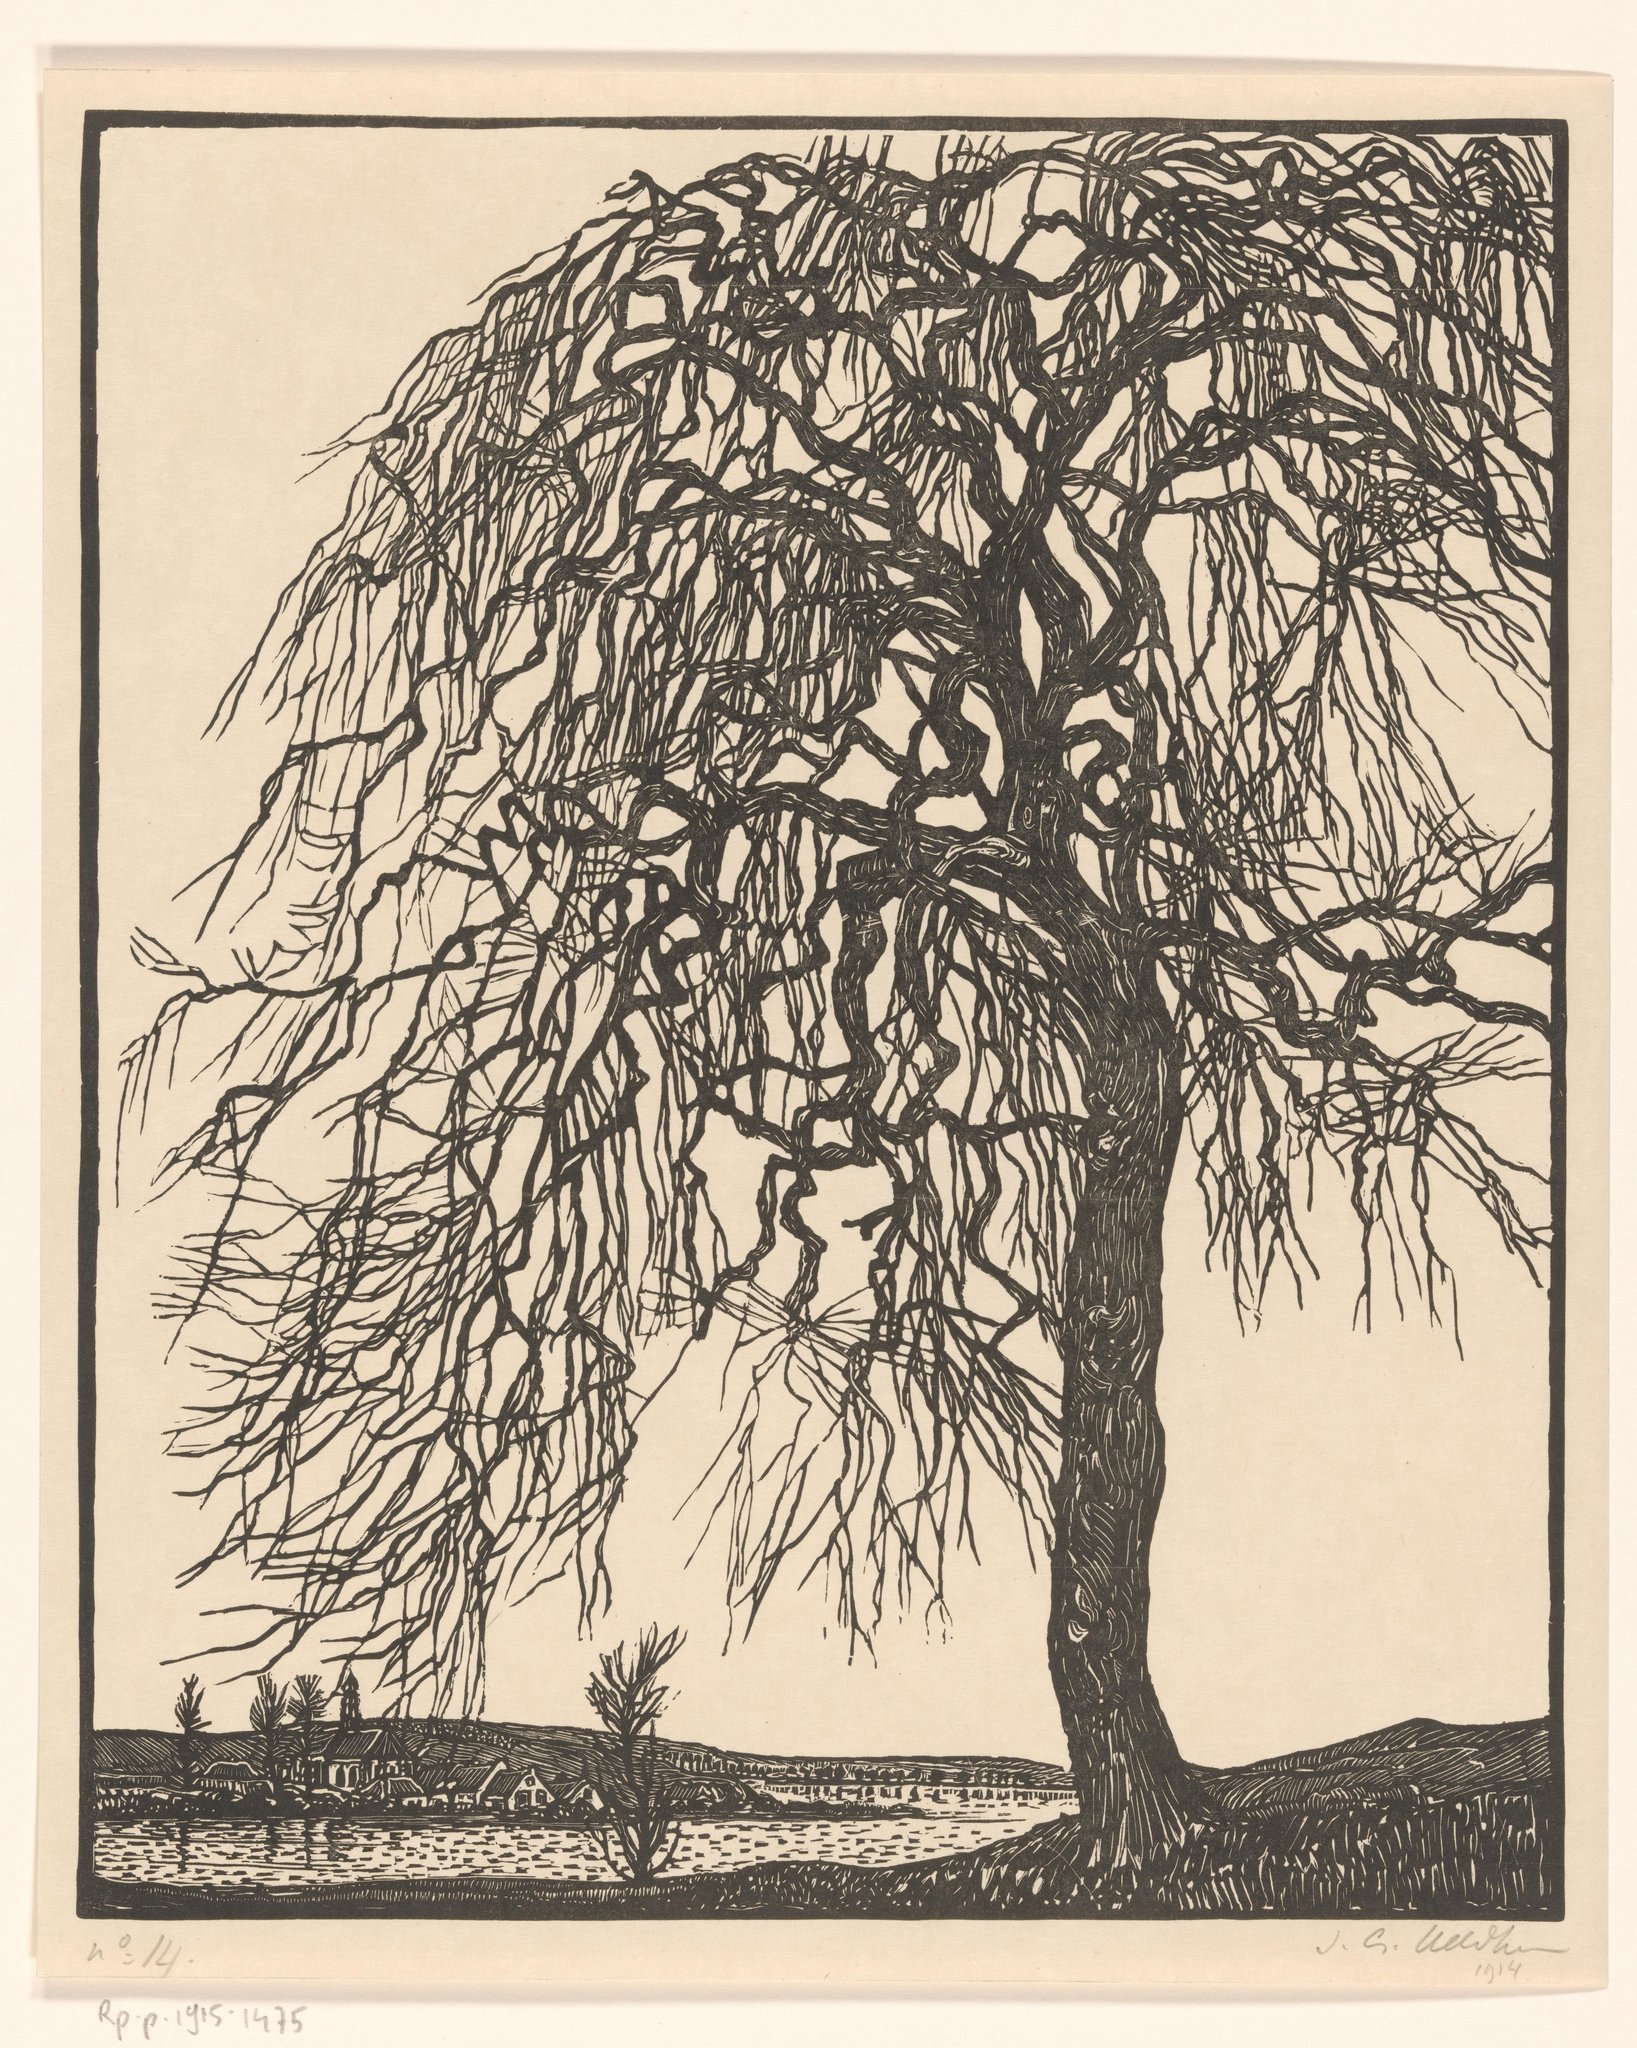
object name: print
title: Landschap met boom aan het water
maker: jacobus gerardus veldheer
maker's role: draughtsman, print maker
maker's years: 1866-1954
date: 1914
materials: paper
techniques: woodcut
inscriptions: annotation: ‘No 14’, collector's mark: Lugt 2233